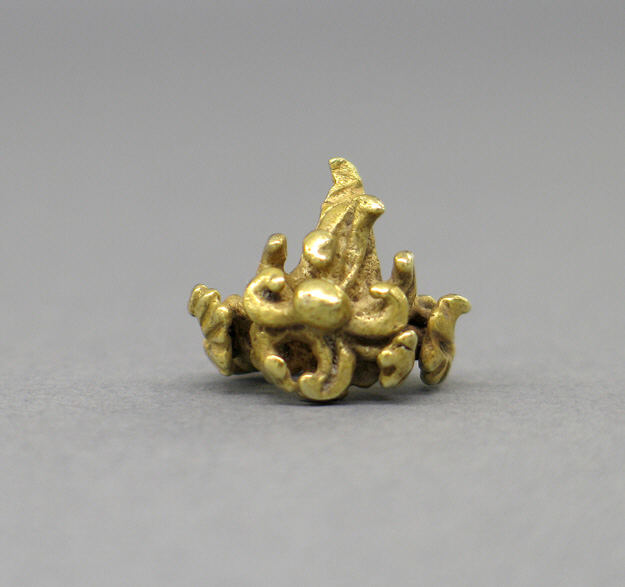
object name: ear ornament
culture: indonesian, javanese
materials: gold